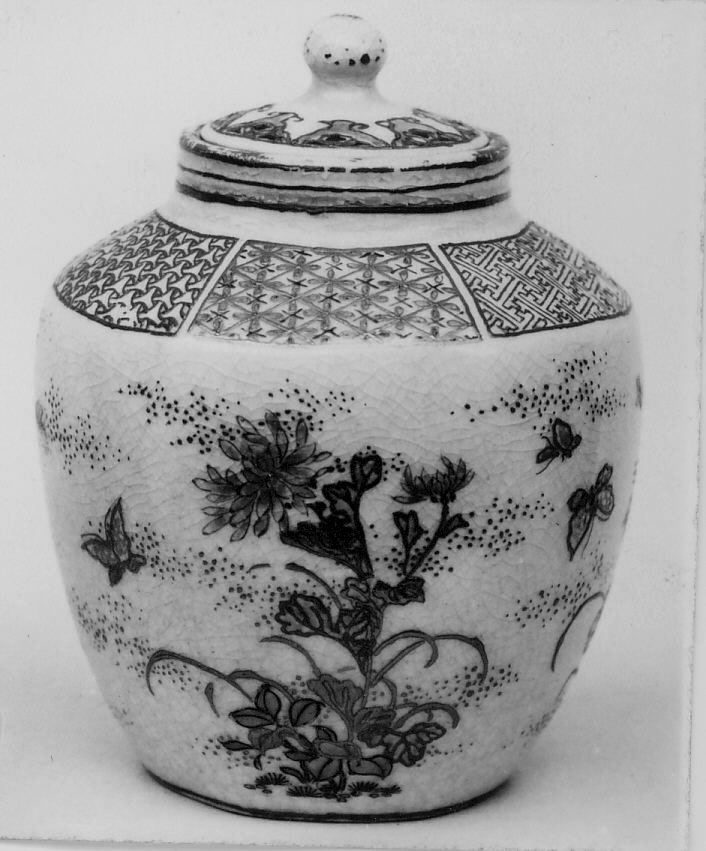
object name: covered jar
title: Miniature Covered Jar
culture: japanese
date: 1767-1800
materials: enamel, glaze, gold, porcelain